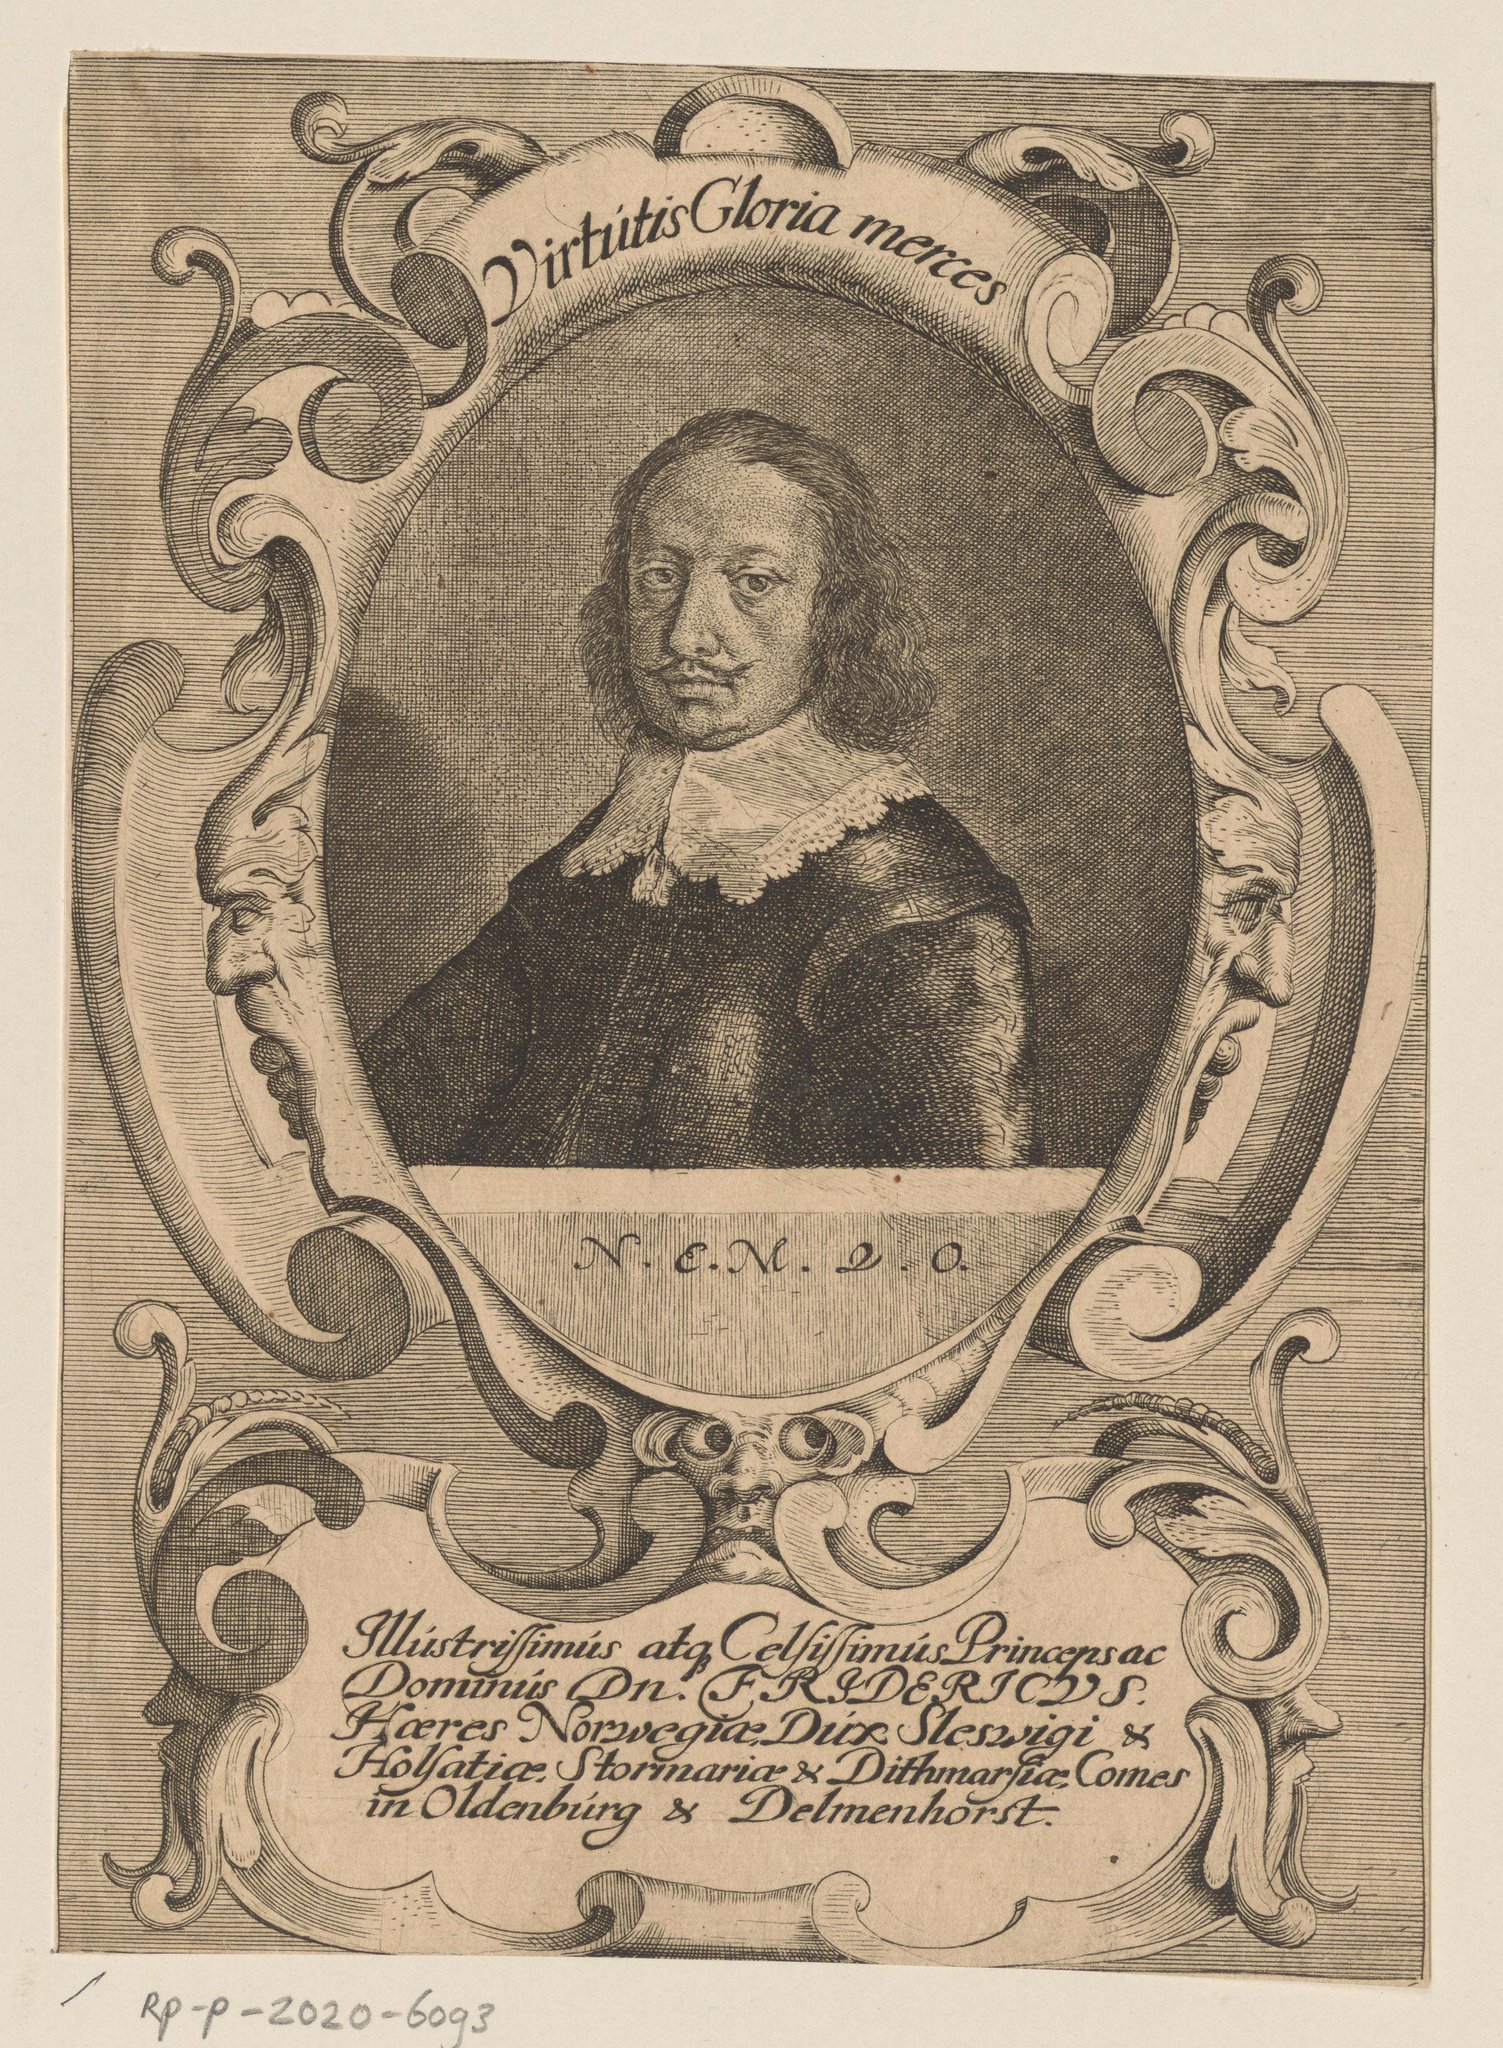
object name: print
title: Portret van Frederik III van Sleeswijk-Holstein-Gottorp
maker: Anonymous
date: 1616-1700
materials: paper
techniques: engraving, etching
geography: germany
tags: rocaille ornament, historical persons, ornament ~ cartouche